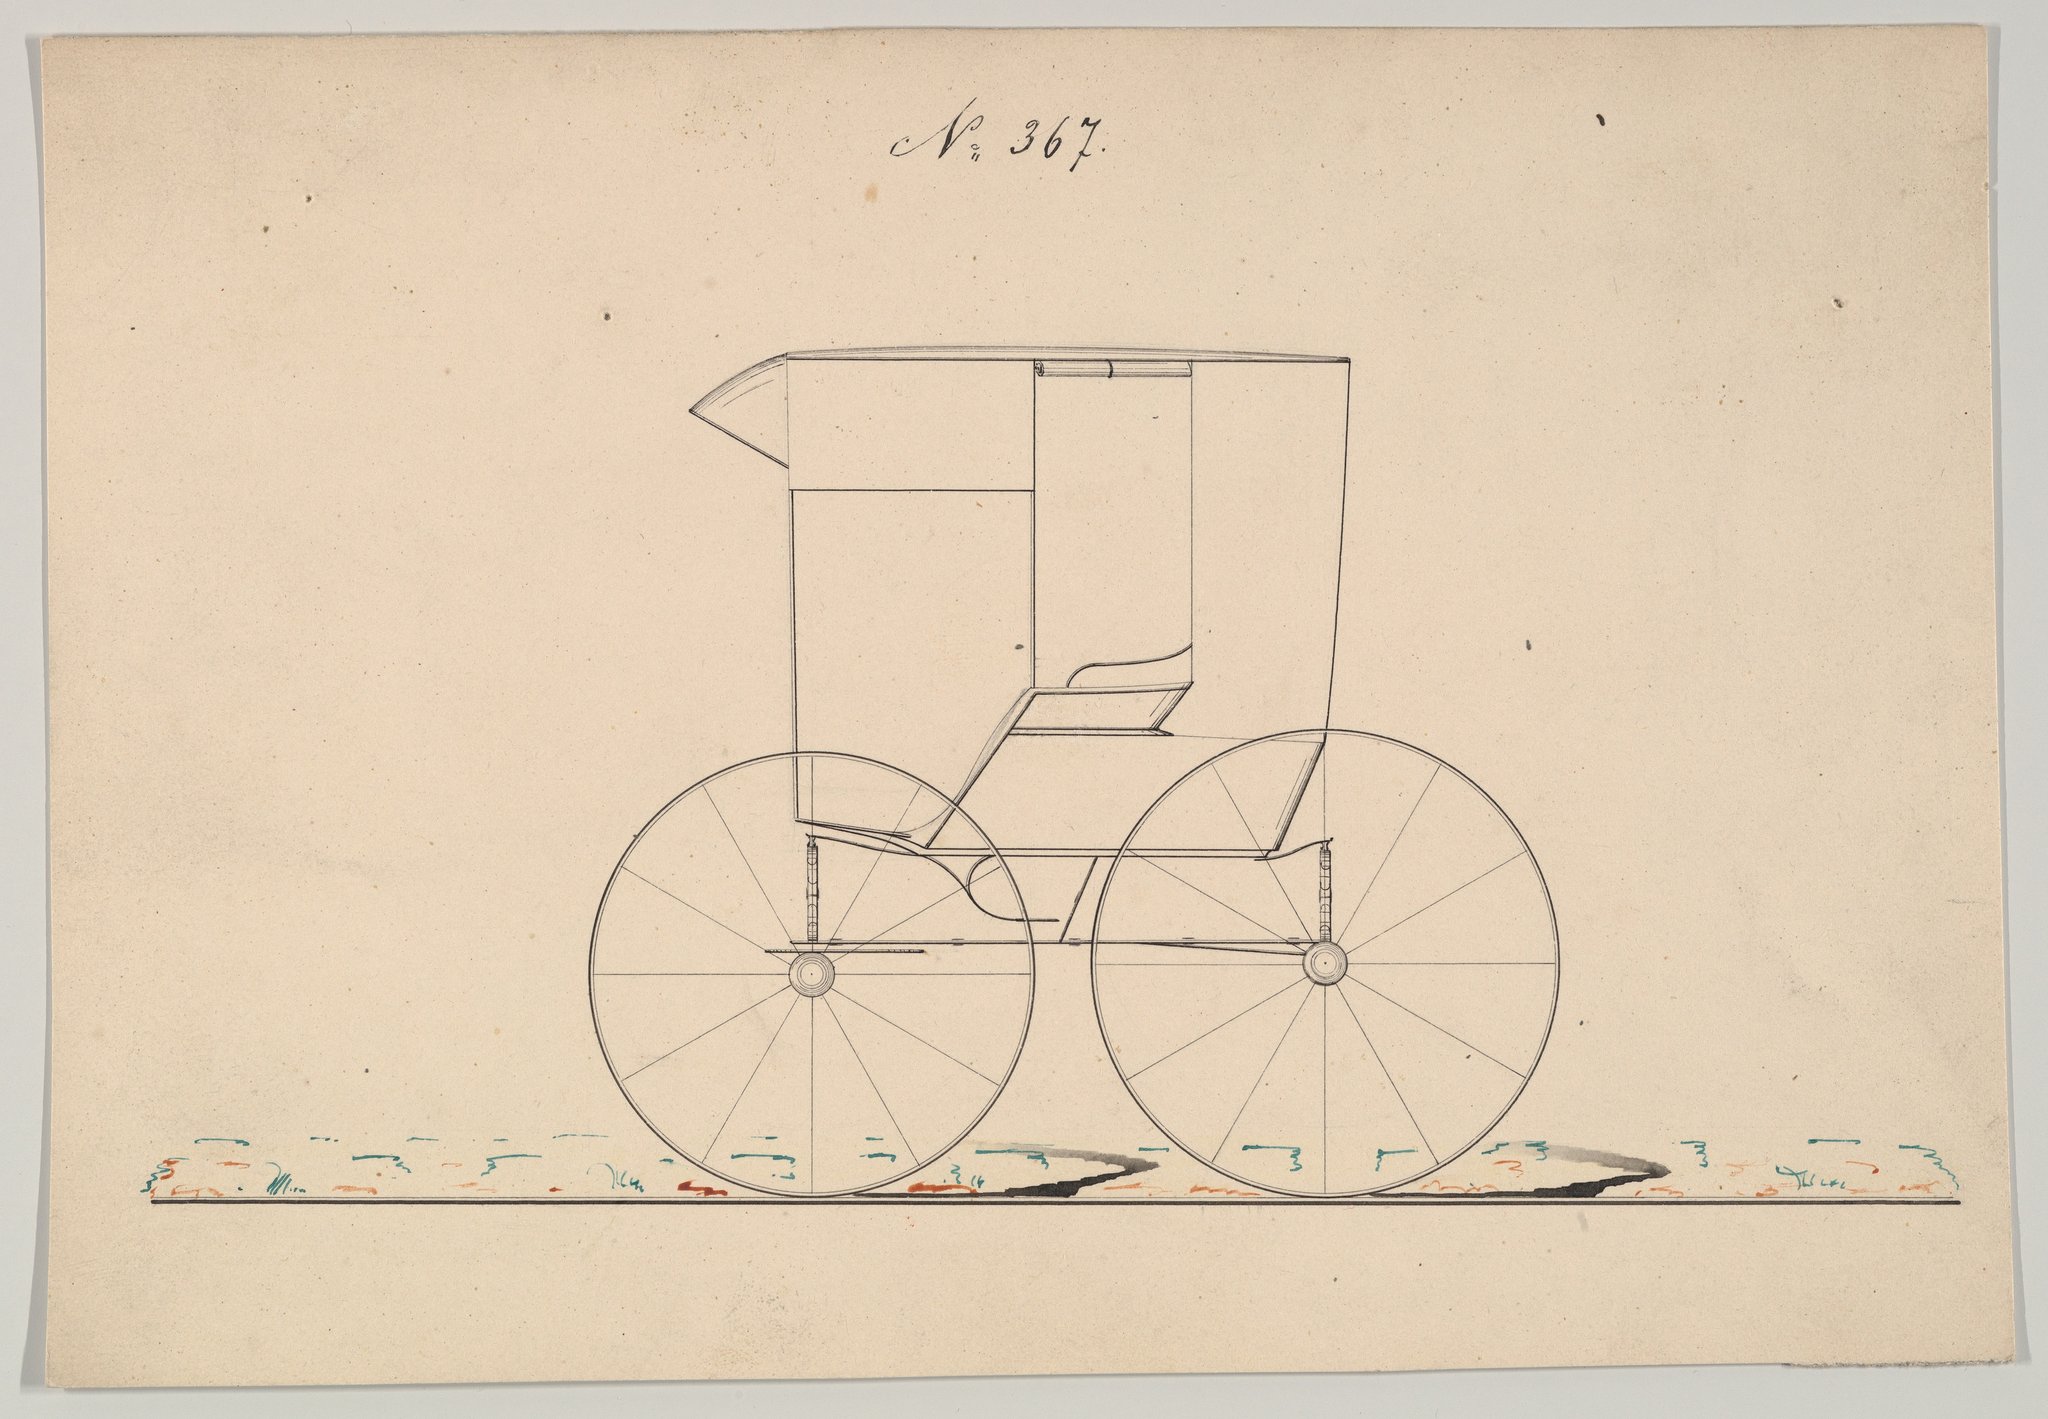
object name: drawing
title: Philadelphia Wagon #367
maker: brewster & co.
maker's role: manufacturer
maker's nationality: american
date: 1865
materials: ink, watercolor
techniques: pen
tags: carriages